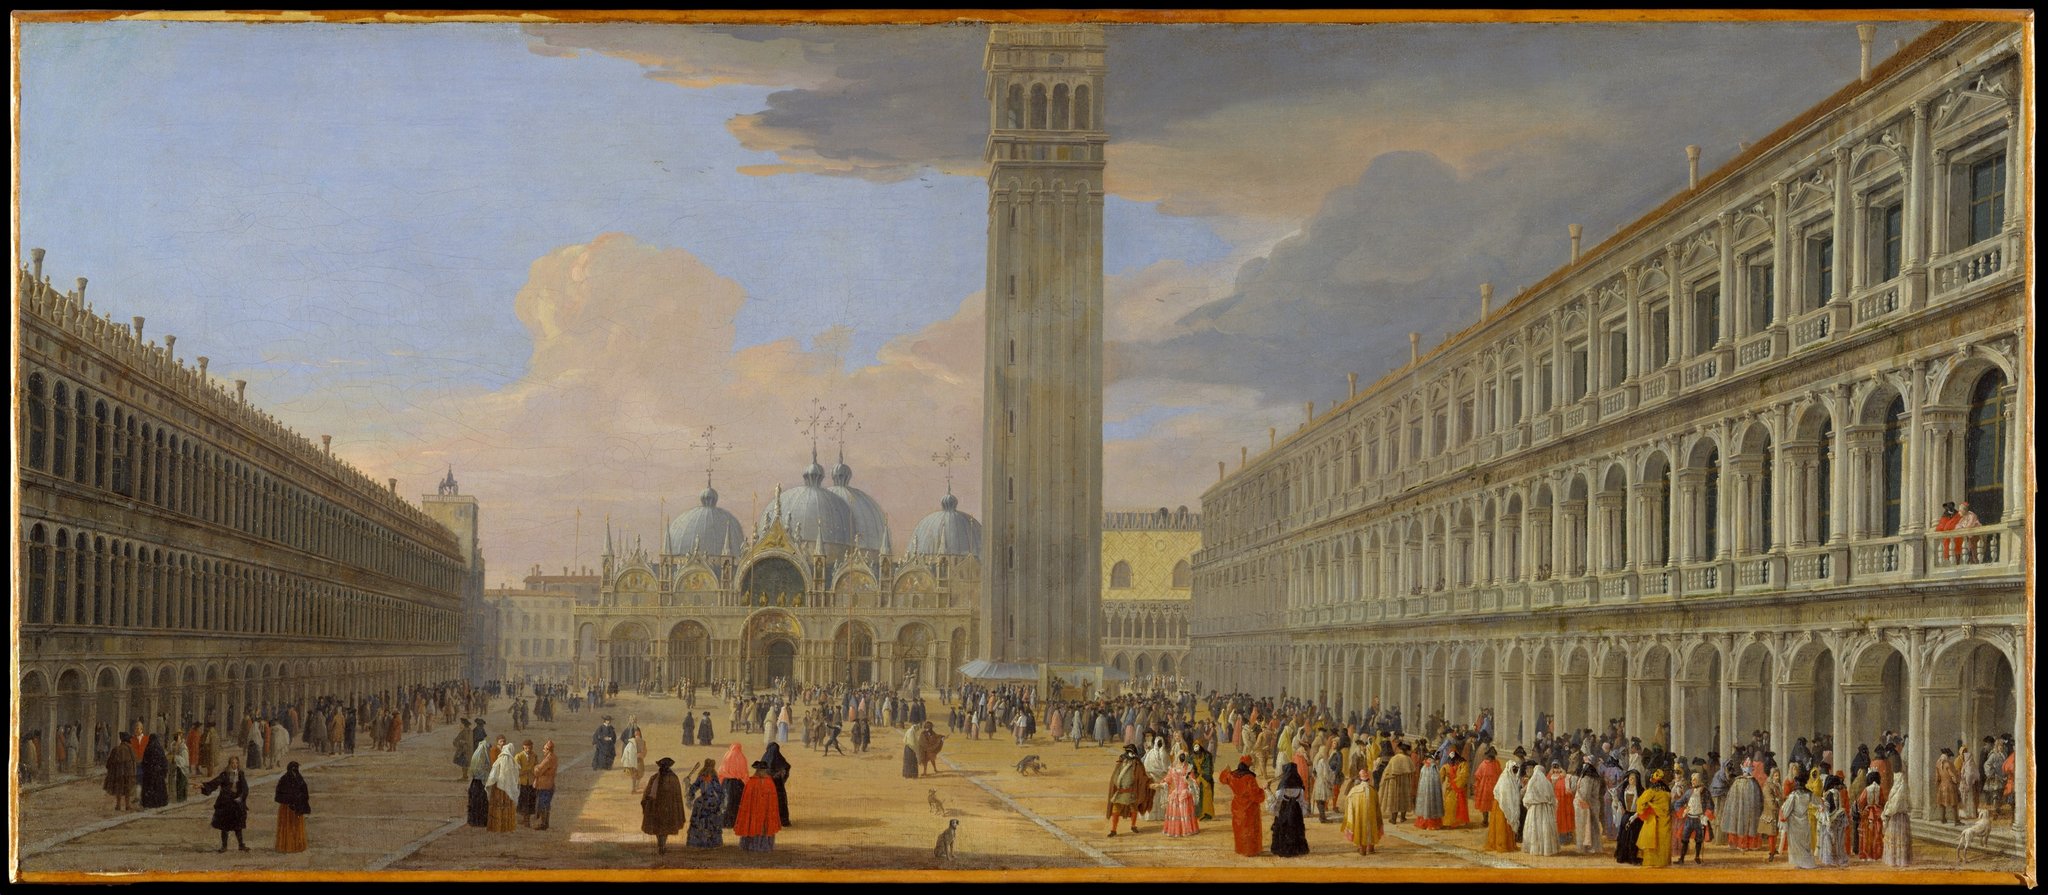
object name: painting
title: Piazza San Marco, Venice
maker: luca carlevaris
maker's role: artist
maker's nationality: italian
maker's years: 1663-1730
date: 1709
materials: canvas, oil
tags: buildings,cities